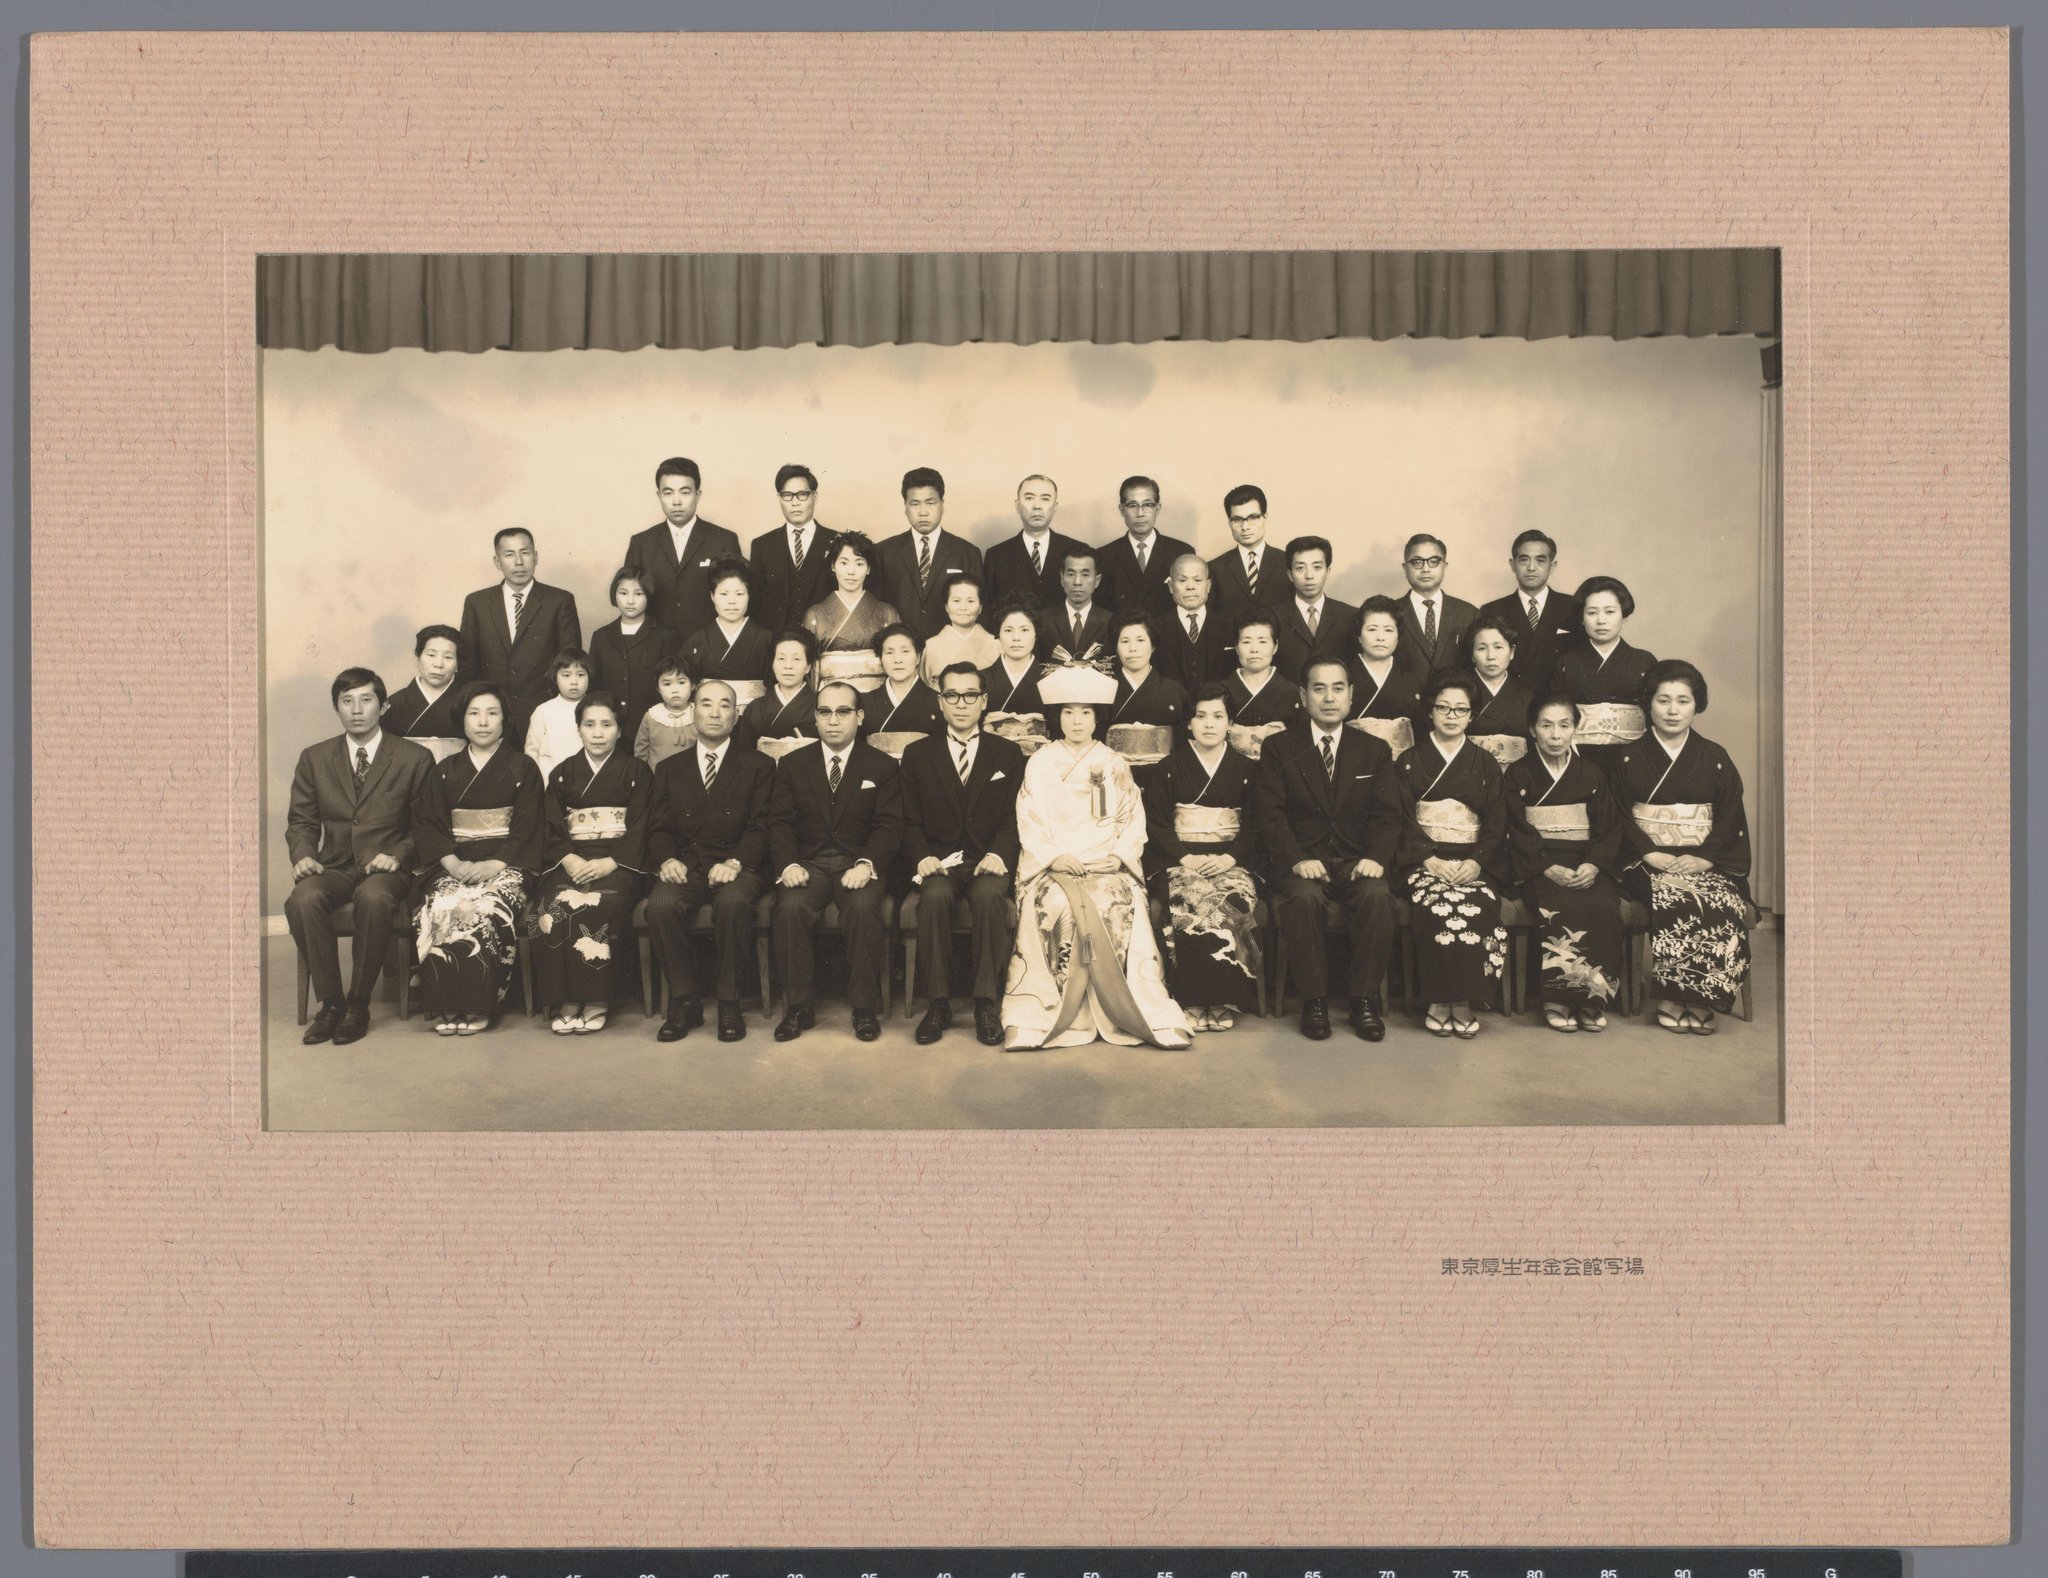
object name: photograph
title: Groepsportret met onbekende Japanse mannen en vrouwen, mogelijk voor een bruiloft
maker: Anonymous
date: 1930-1960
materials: paper, cardboard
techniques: gelatin silver print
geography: japan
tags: anonymous historical persons portrayed in a group, in a group-portrait, japan